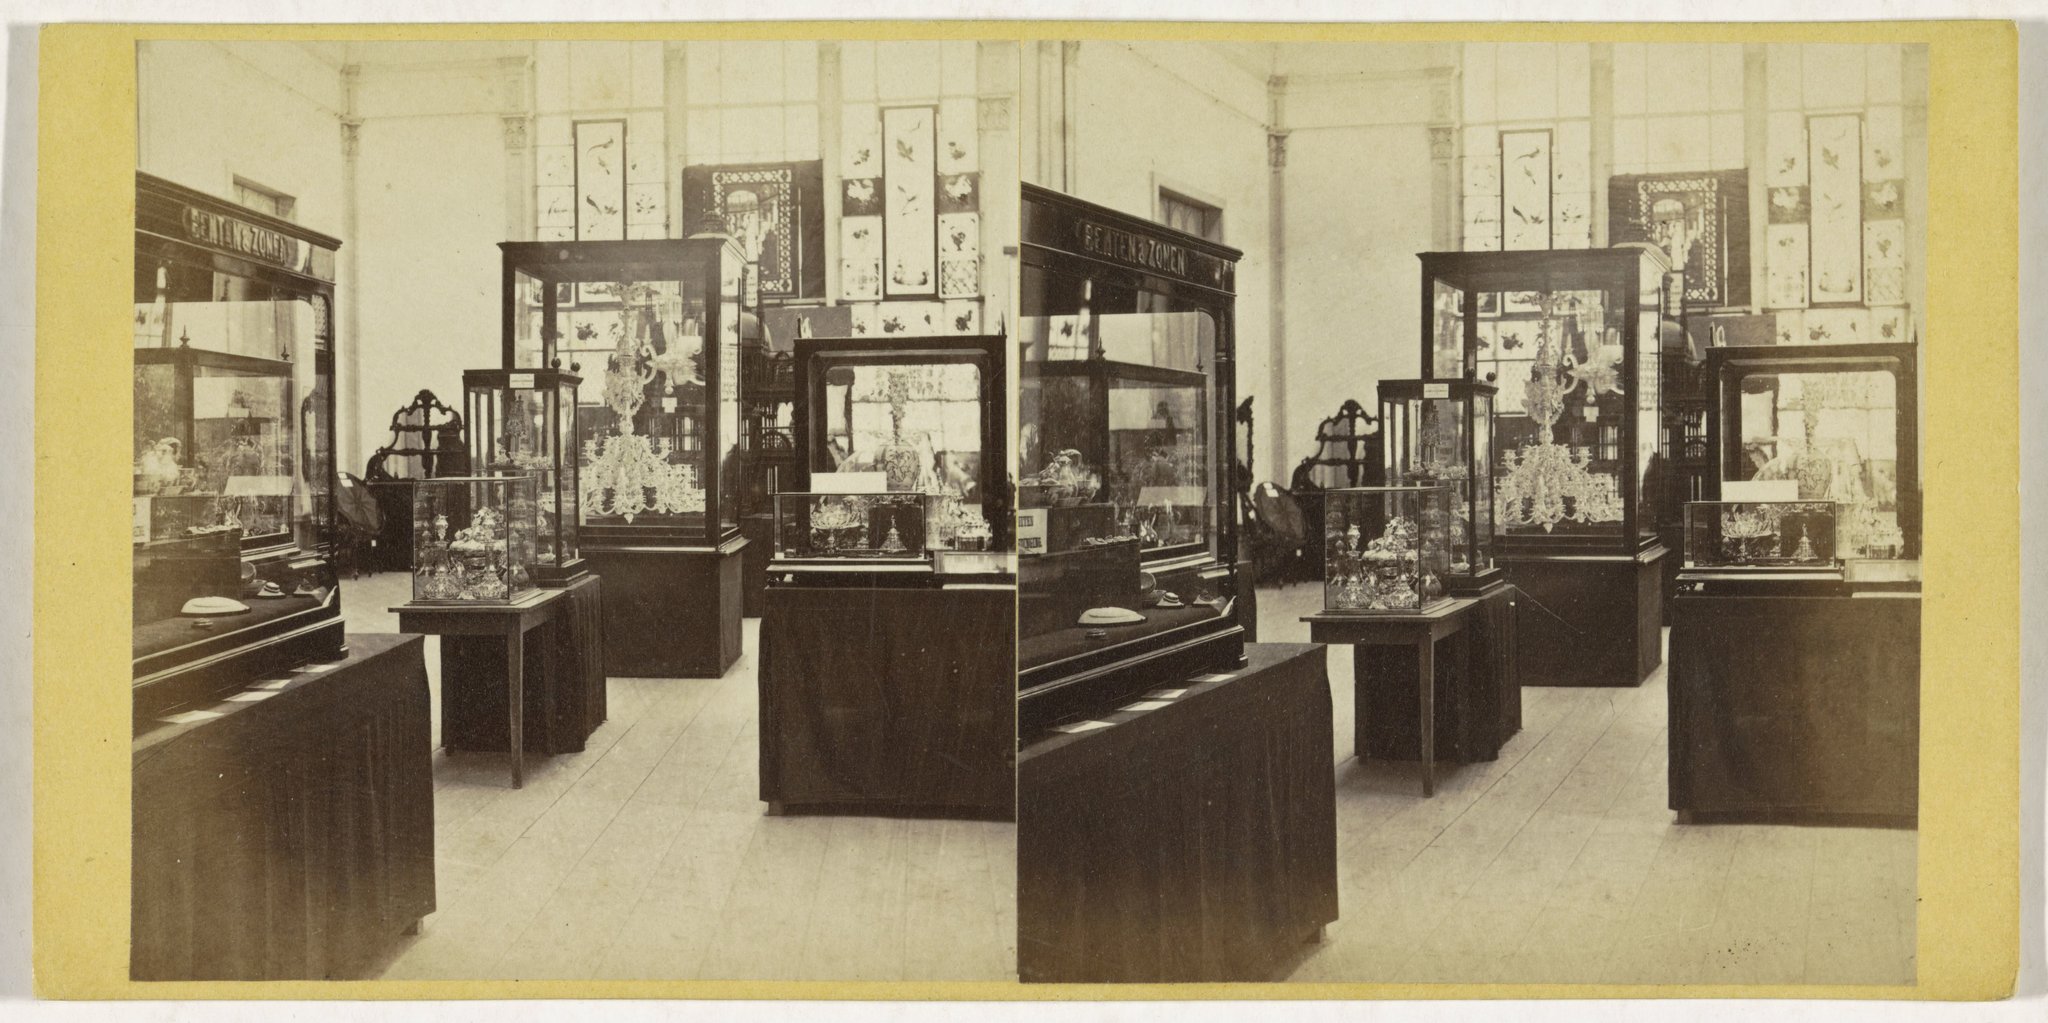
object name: stereograph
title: Objecten in vitrinekasten bij de tentoonstelling voor Nationale Nijverheid en Kunst in het Paleis voor Volksvlijt, Amsterdam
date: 1866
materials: cardboard, paper, photographic support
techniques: albumen print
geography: amsterdam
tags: amsterdam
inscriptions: stamp: ‘JDB’, label: ‘Boek & Kunsthandel Jan D. Brouwer, Kalverstraat E, Nº 37 Amsterdam.’